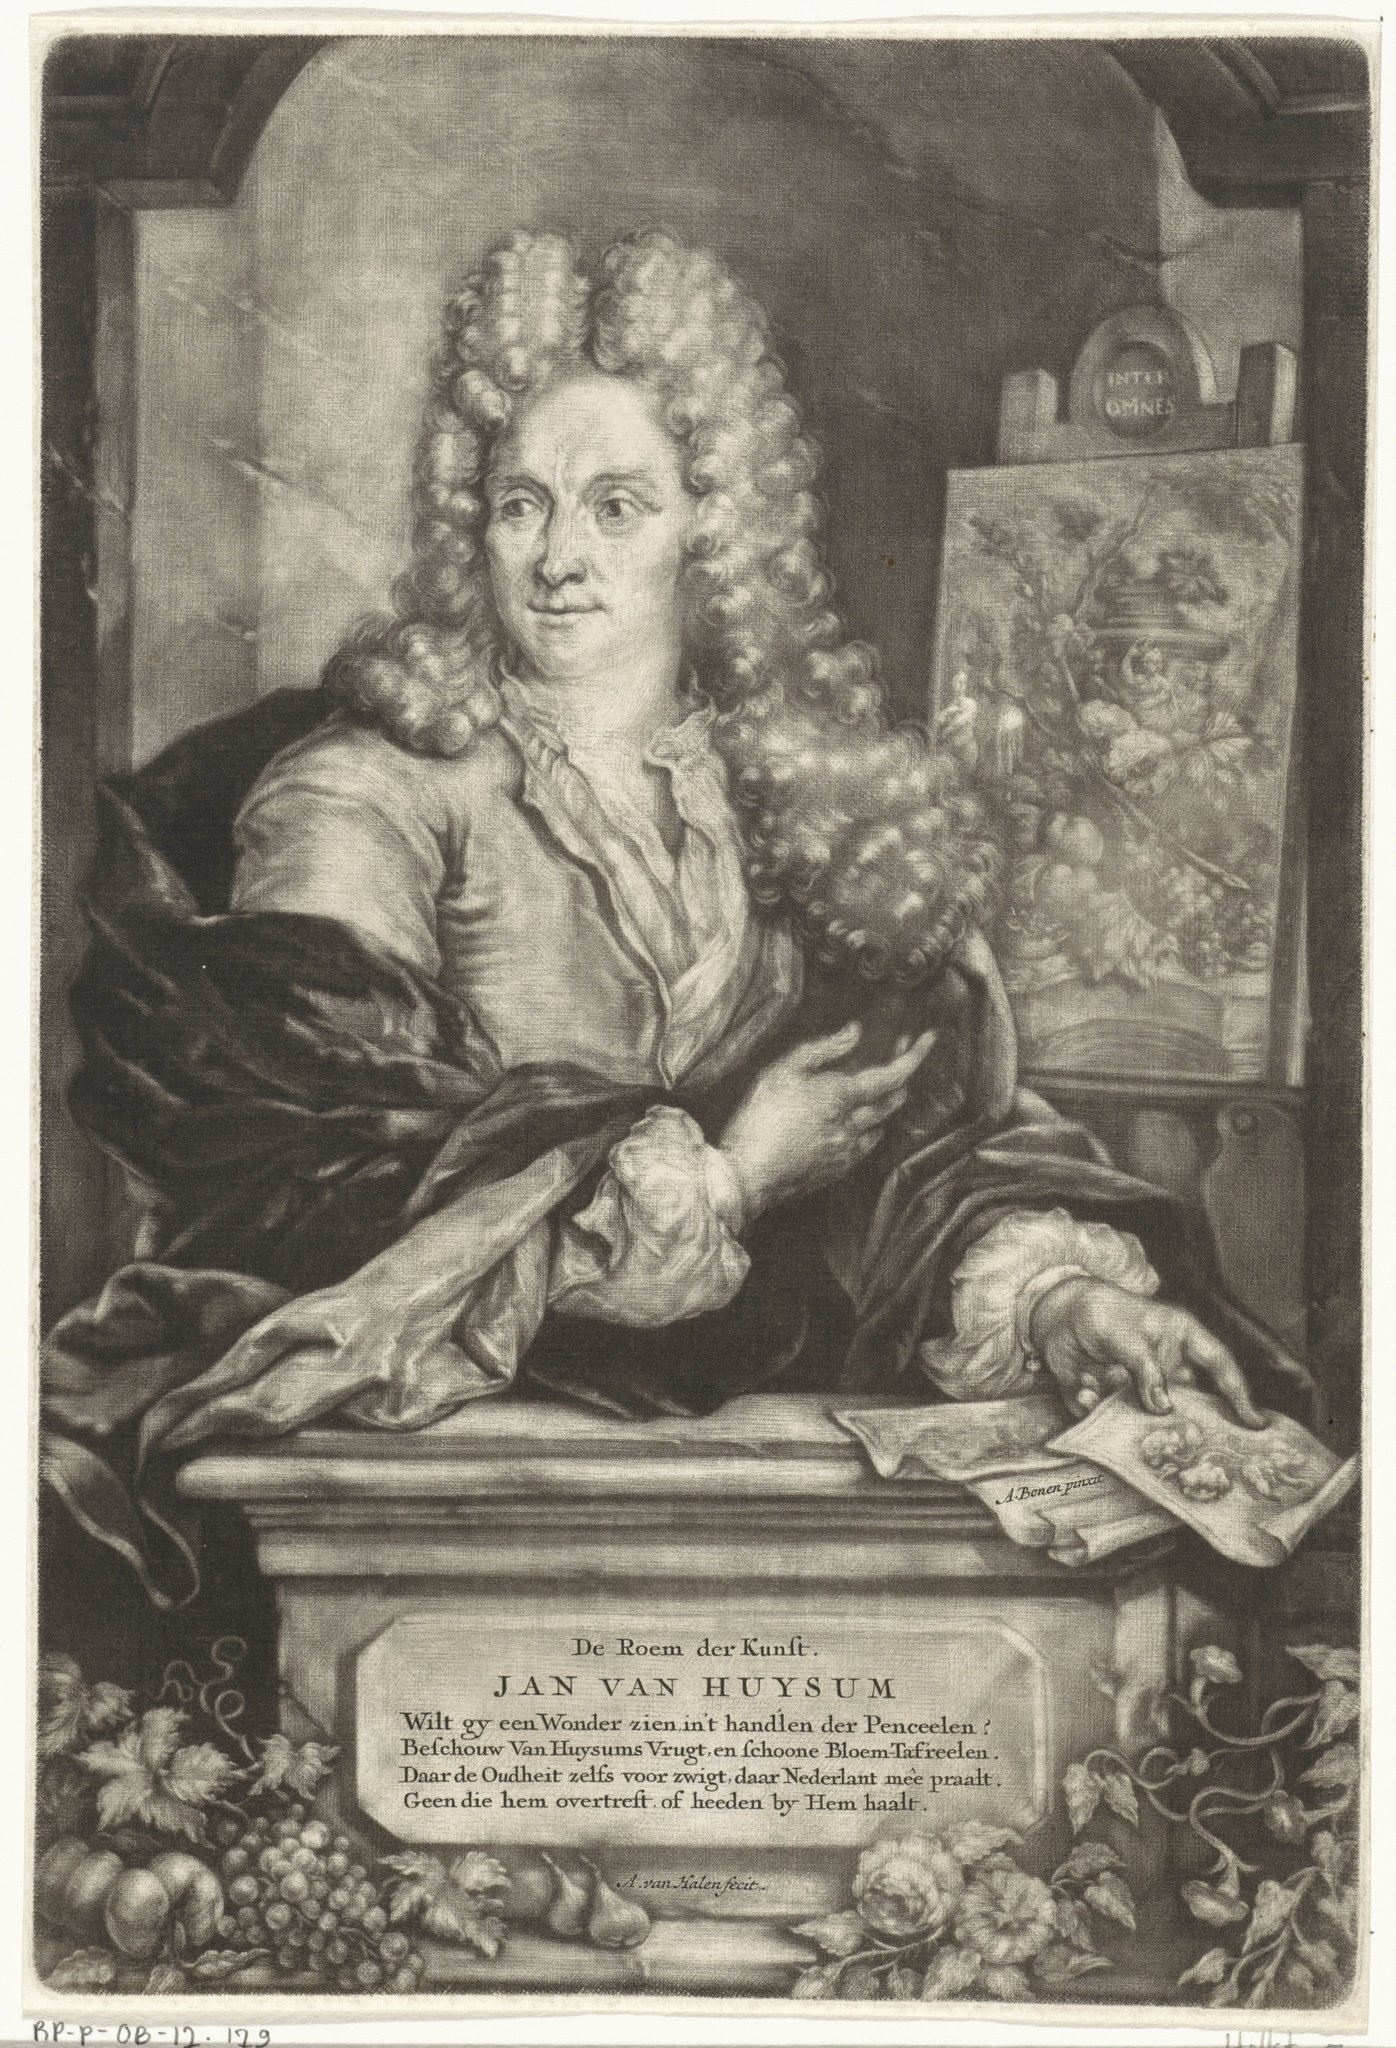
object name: print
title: Portret van Jan van Huysum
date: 1702-1732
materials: paper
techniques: engraving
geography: amsterdam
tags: amsterdam, painter, draughtsman, jan van huysum, flowers, portrait, self-portrait of painter, wig, picture, painting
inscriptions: collector's mark: Lugt 2228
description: De bloemschilder Jan van Huysum staat in een nis naast een schilderij waarop een tuin met sculpturen, bloemen en planten. In de hand houdt hij een vel met een afbeelding van een bloem. Op de plint een lofdicht over de kwaliteit van het werk van Jan van Huysum.